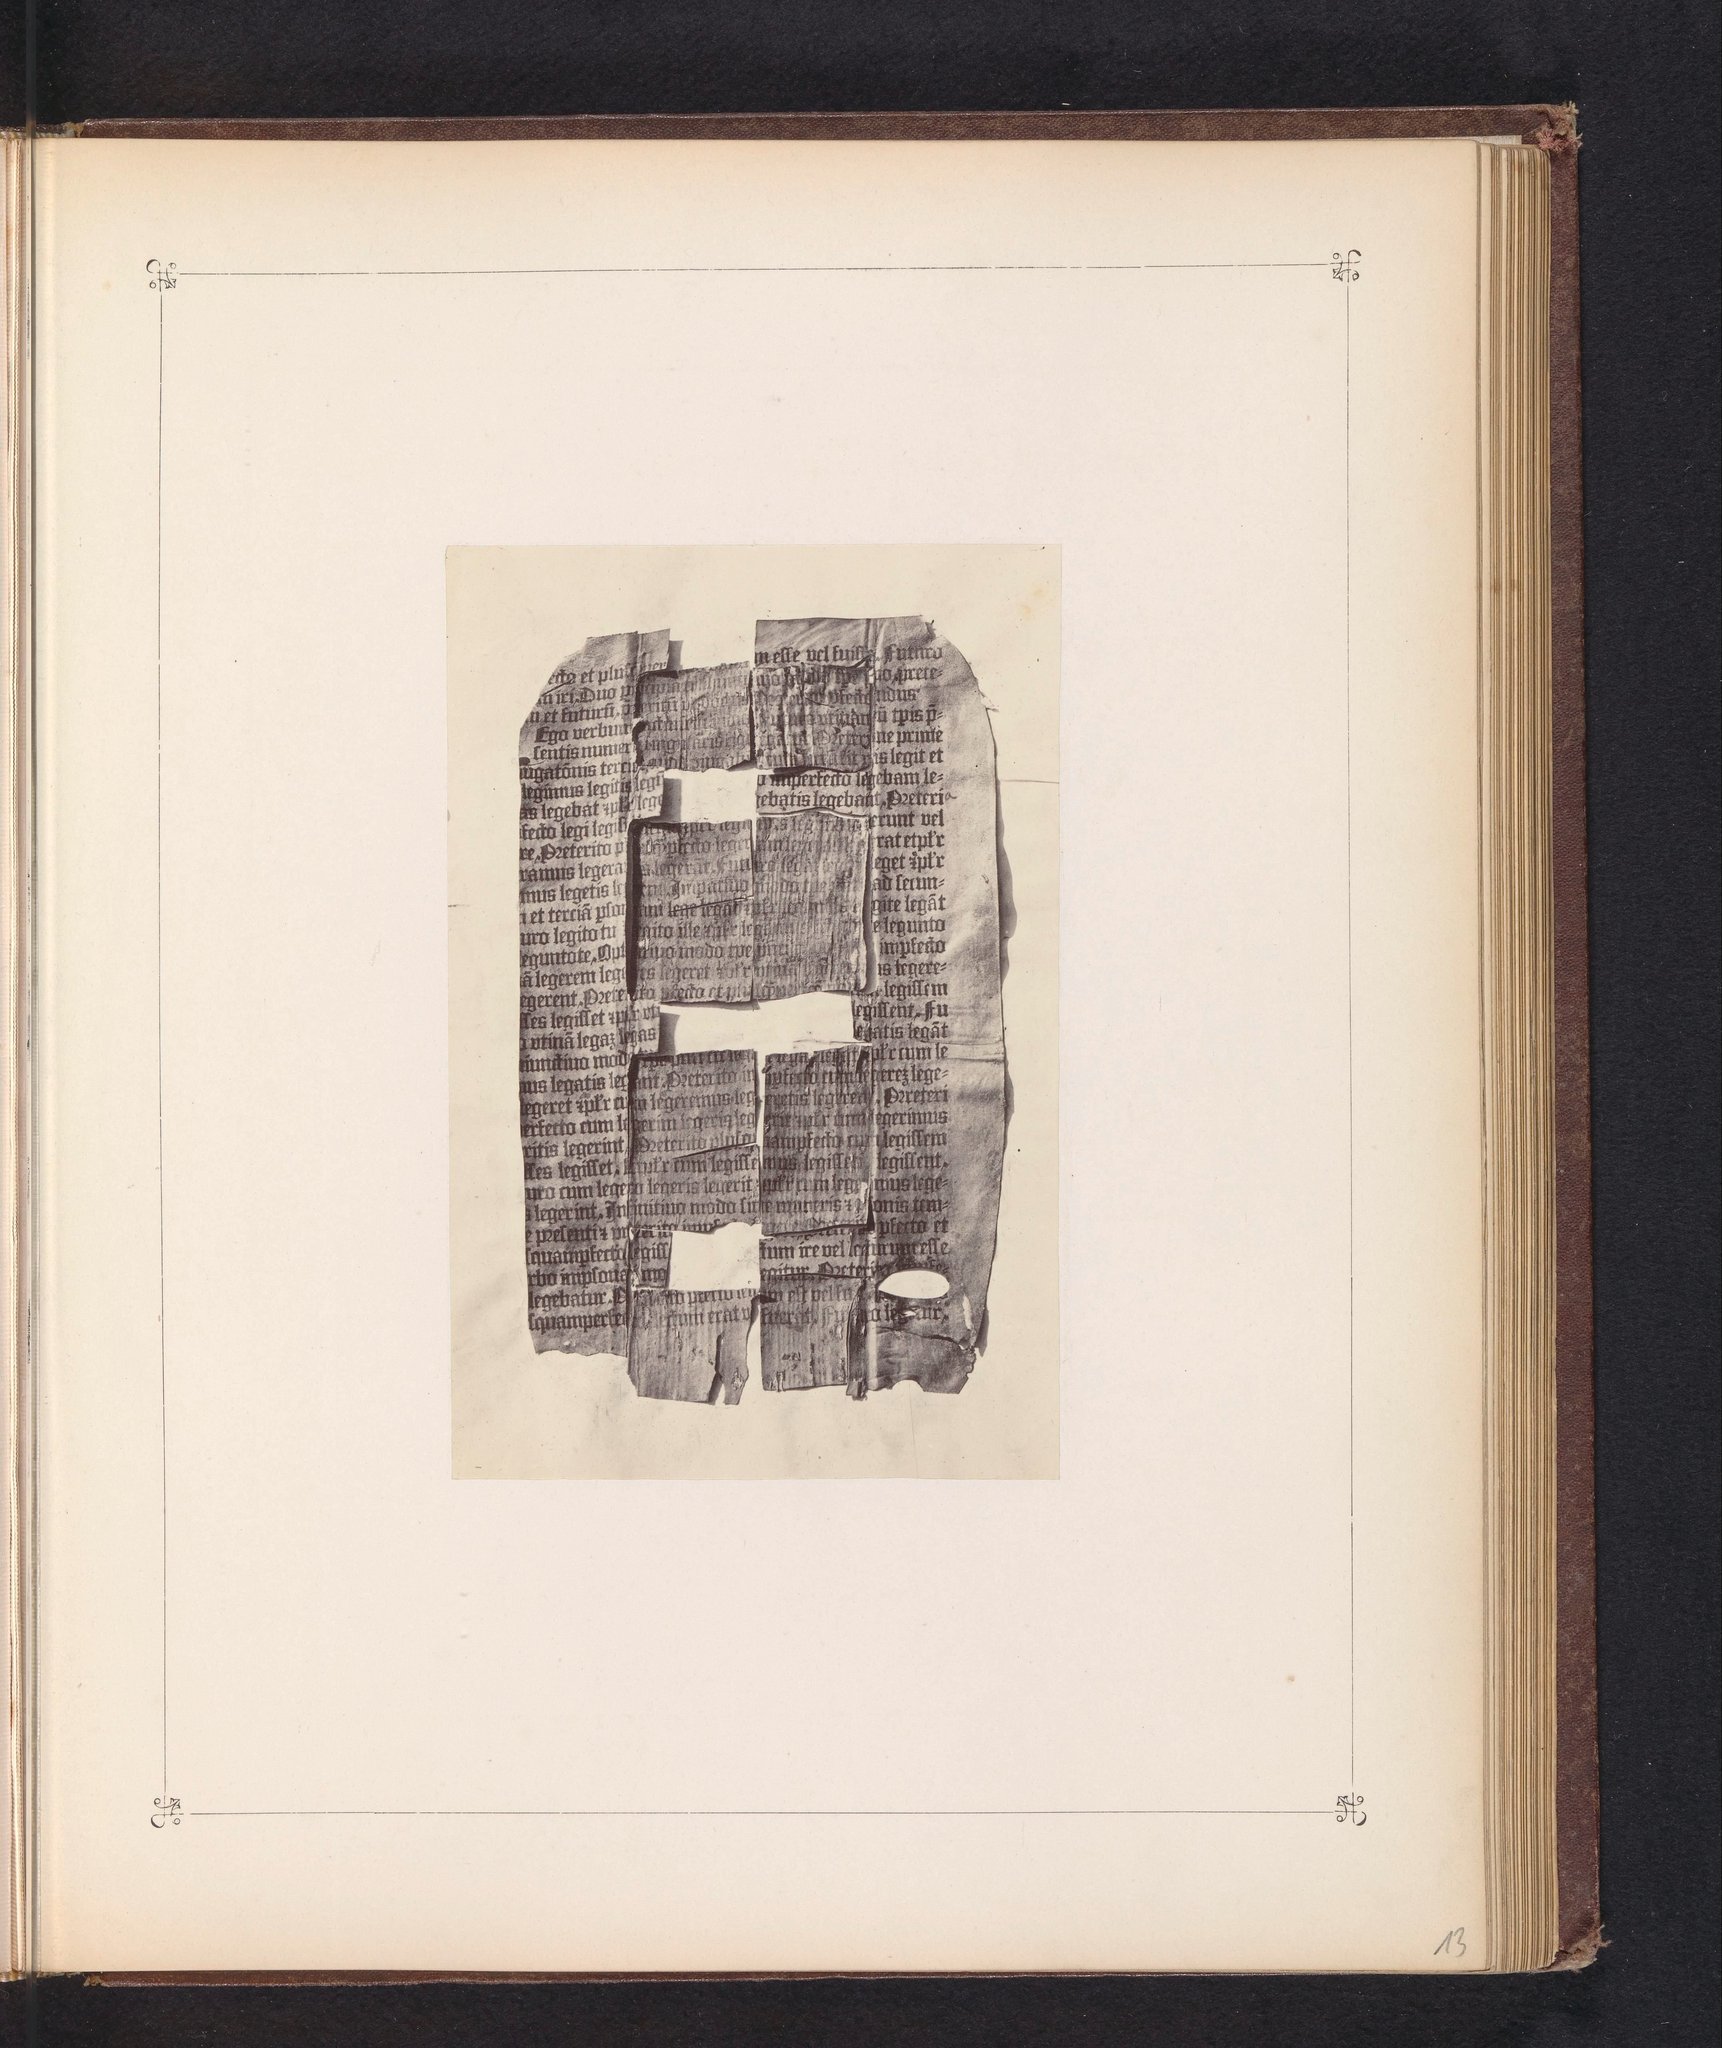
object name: photograph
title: Pagina van een gedrukte tekst van Donatus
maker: b. erdmann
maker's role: fotograaf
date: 1867-1872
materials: photographic support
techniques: albumen print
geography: mainz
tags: book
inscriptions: number: ‘13’